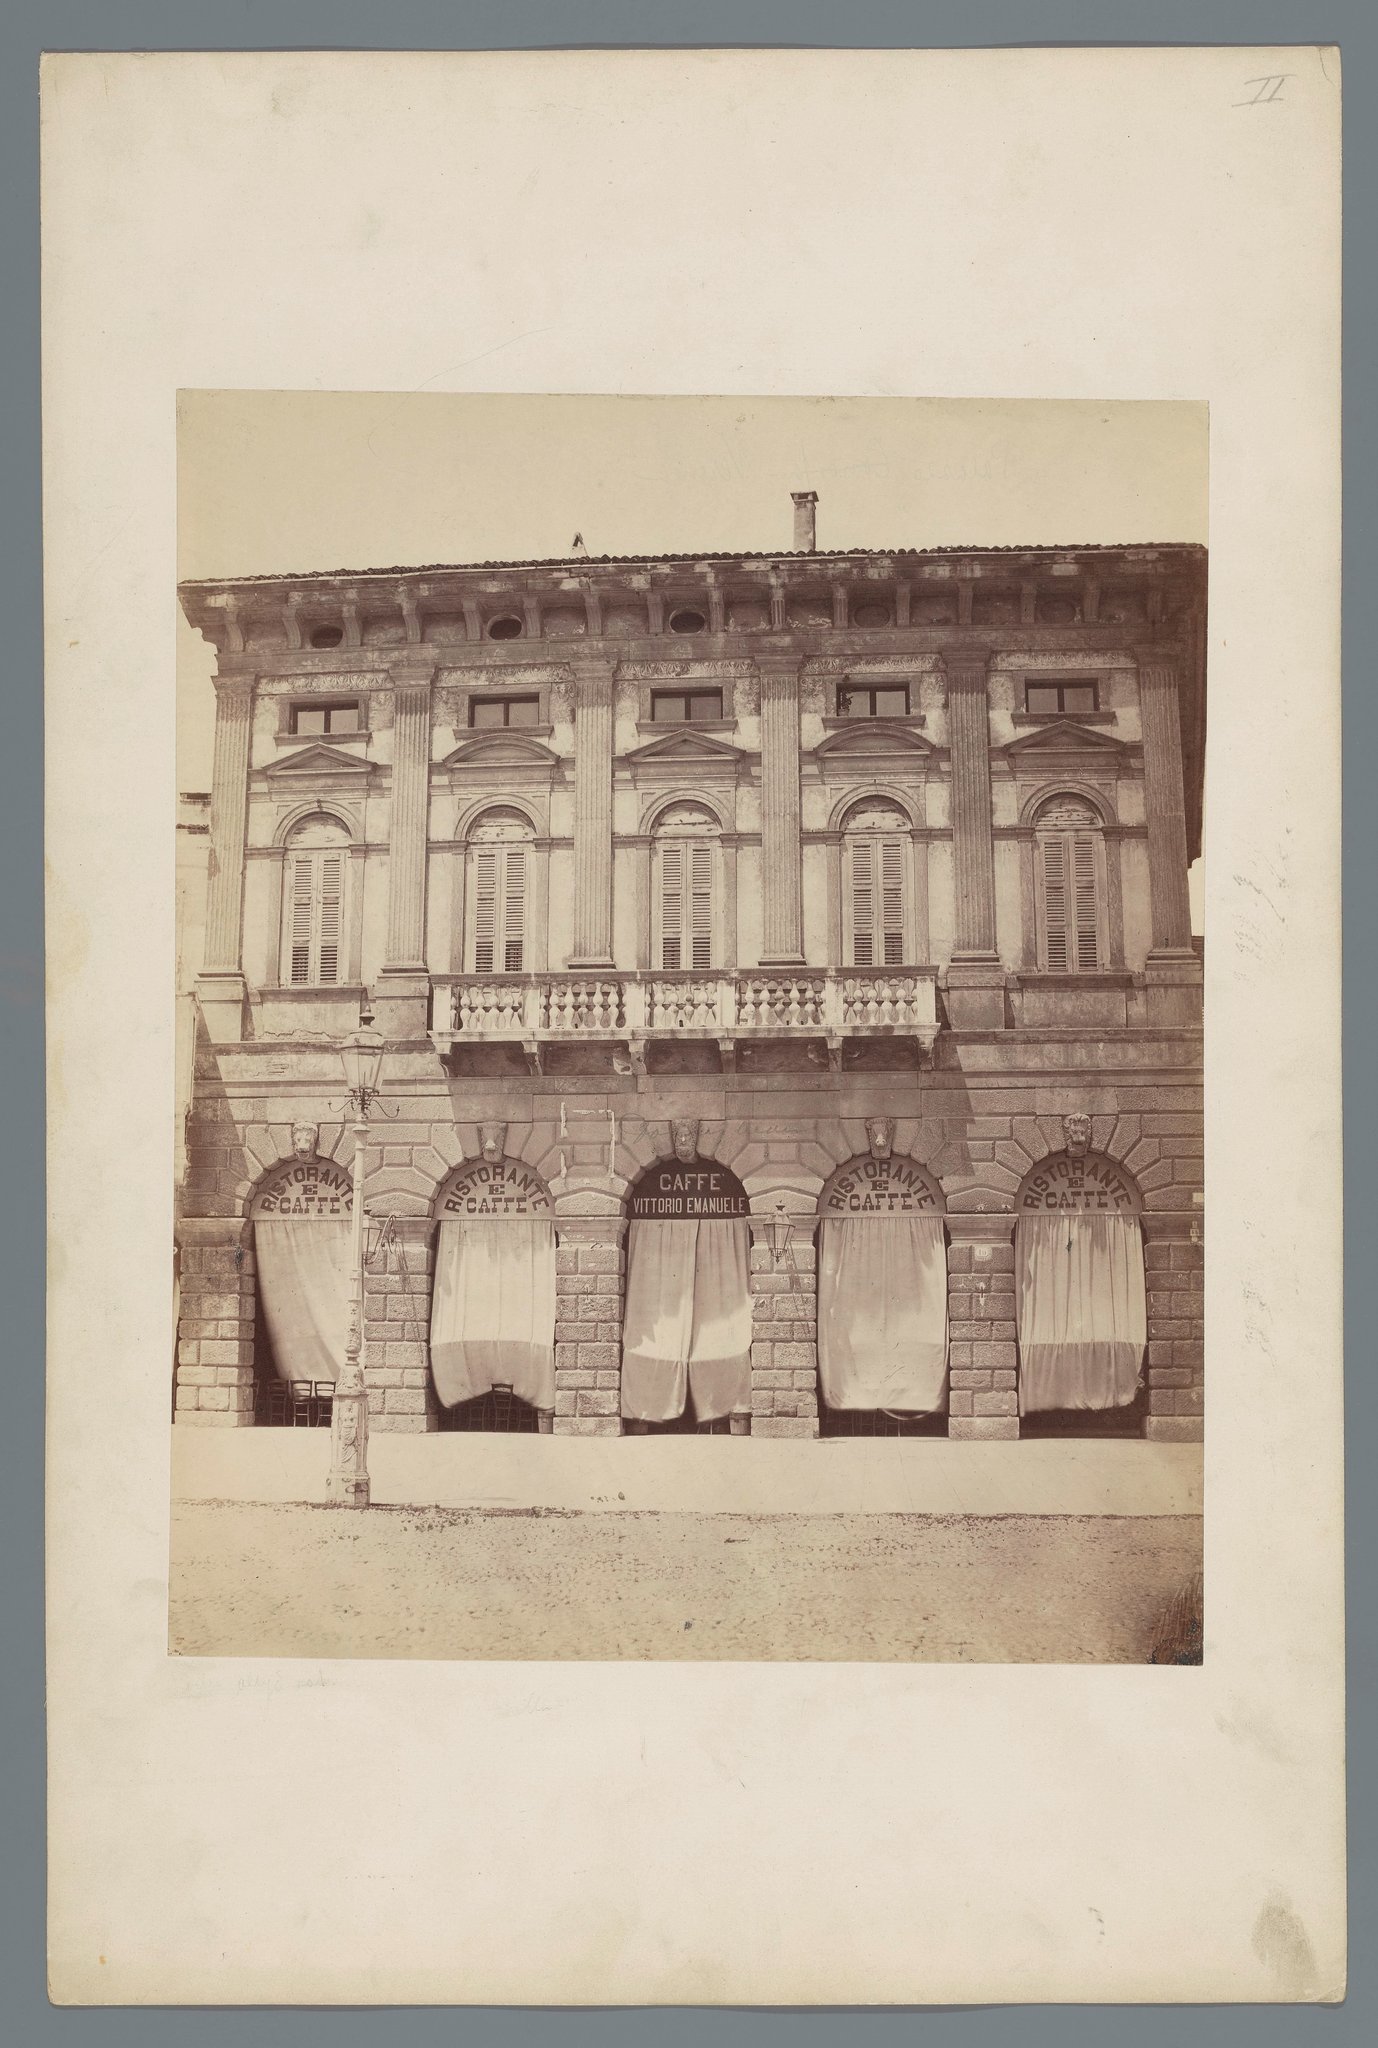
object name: stereograph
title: Gezicht op het Tribunal de commerce en de Pont Notre-Dame in Parijs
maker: Anonymous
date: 1850-1880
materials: cardboard, photographic support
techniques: albumen print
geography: paris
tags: bridge in city across river, canal, etc.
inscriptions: inscription: ‘Tribunal de Commerce Pont Notre [...]’